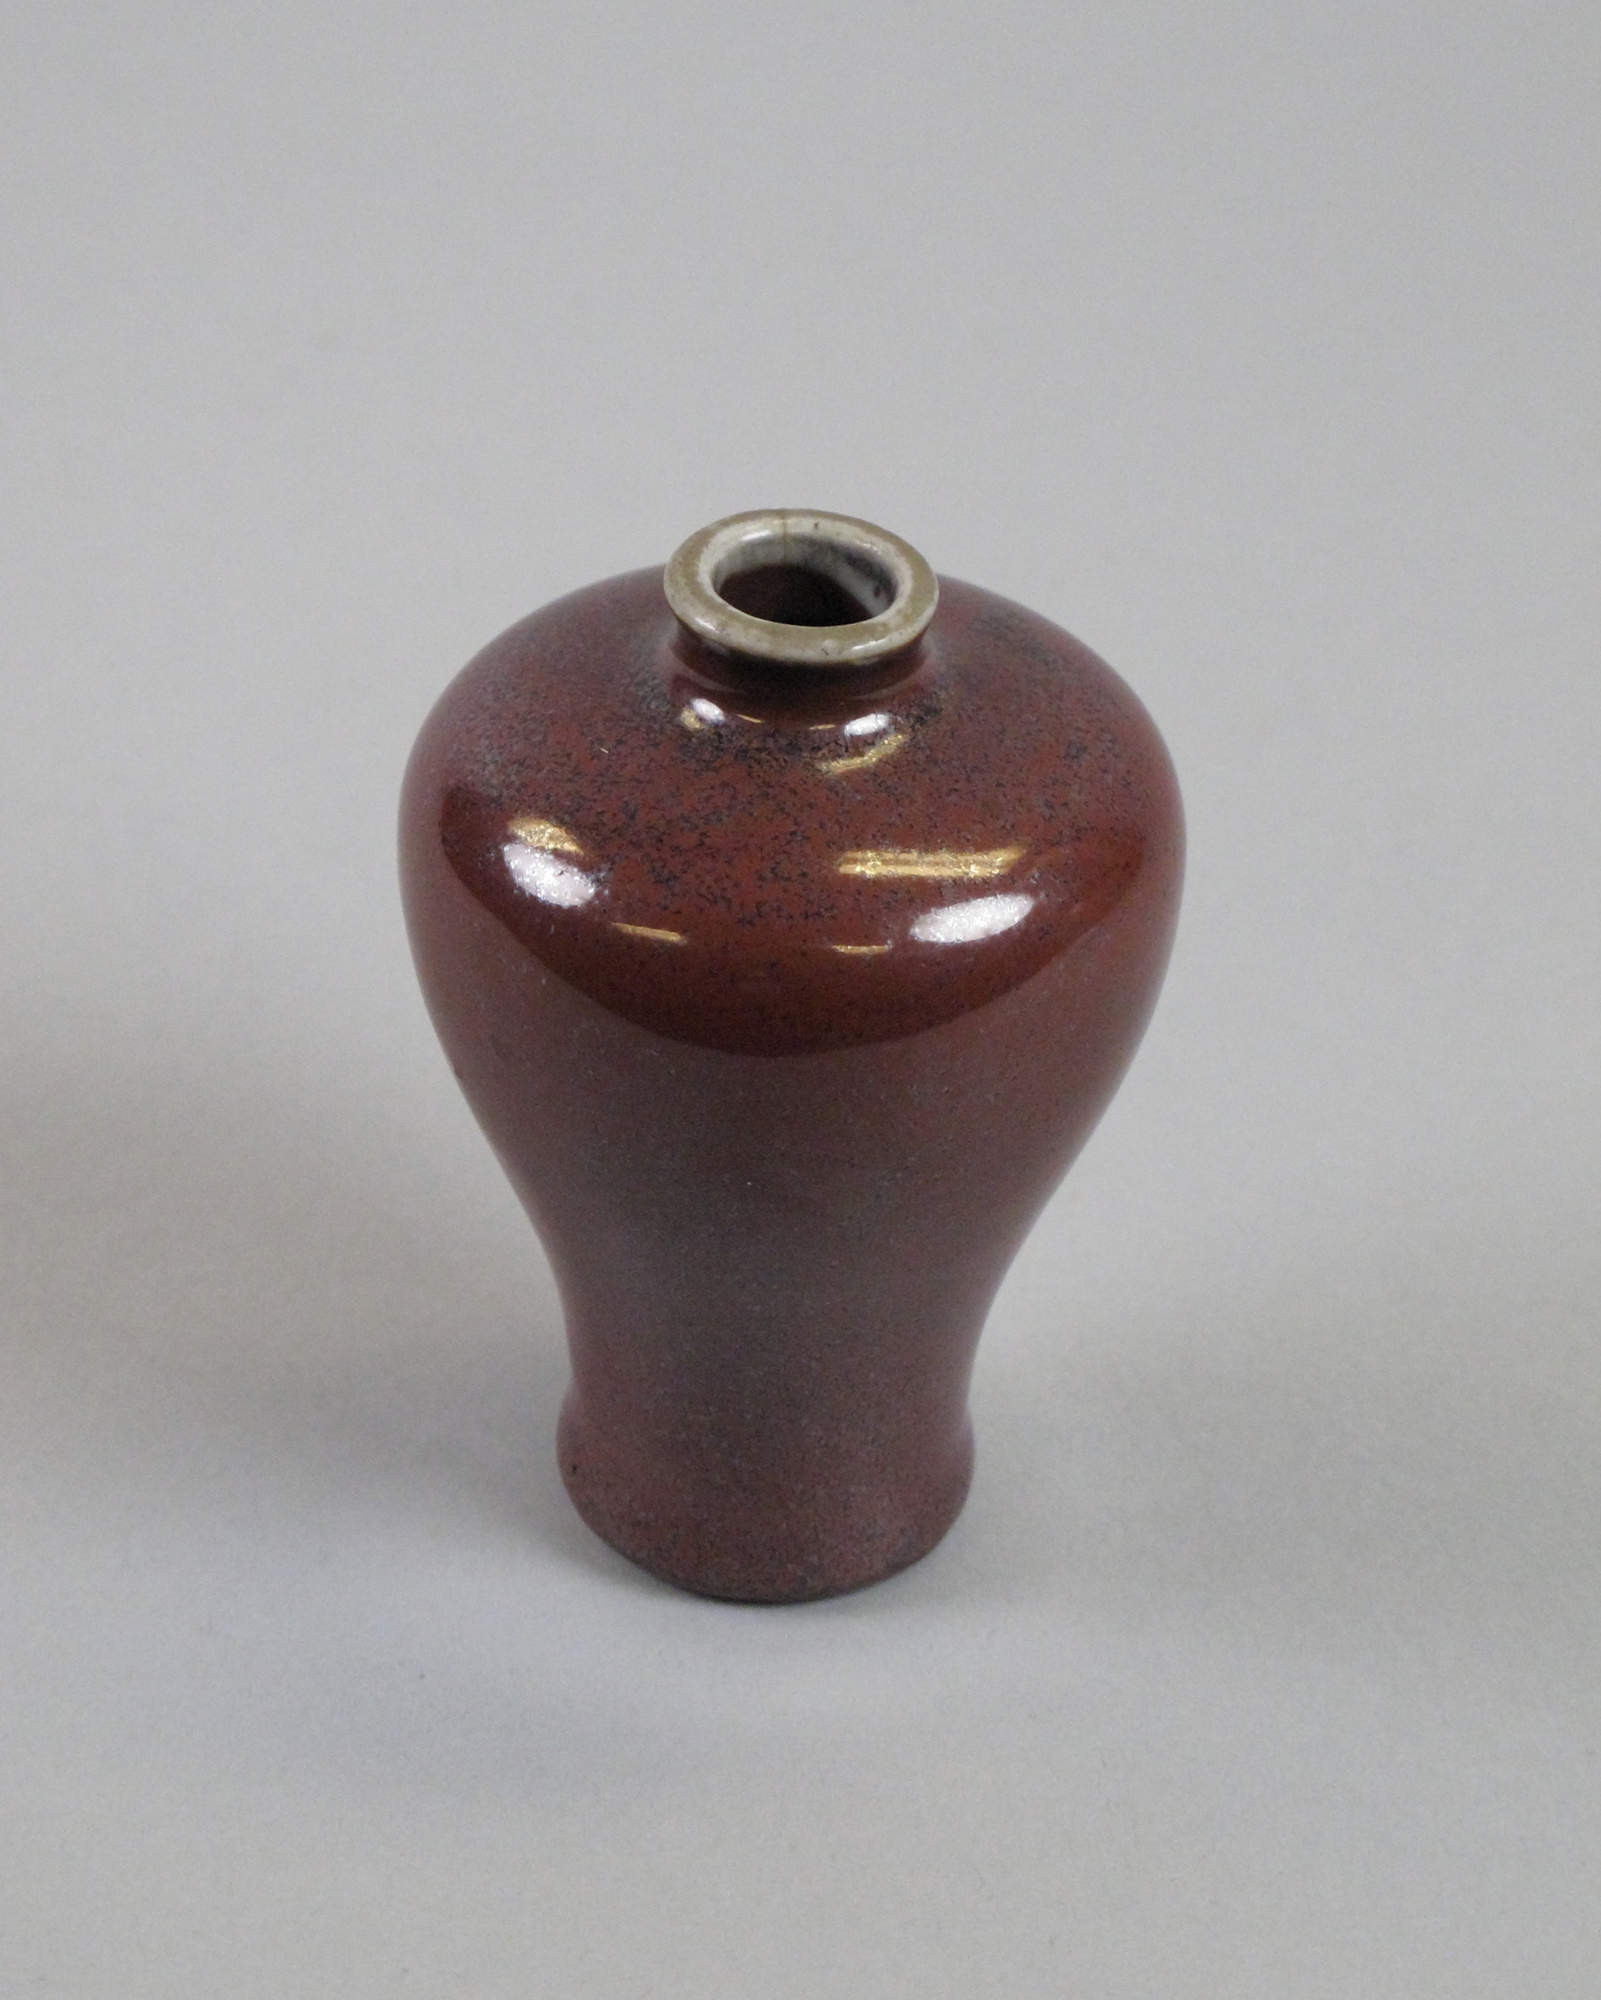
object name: vase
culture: chinese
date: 1801-1900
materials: glaze, iron, porcelain